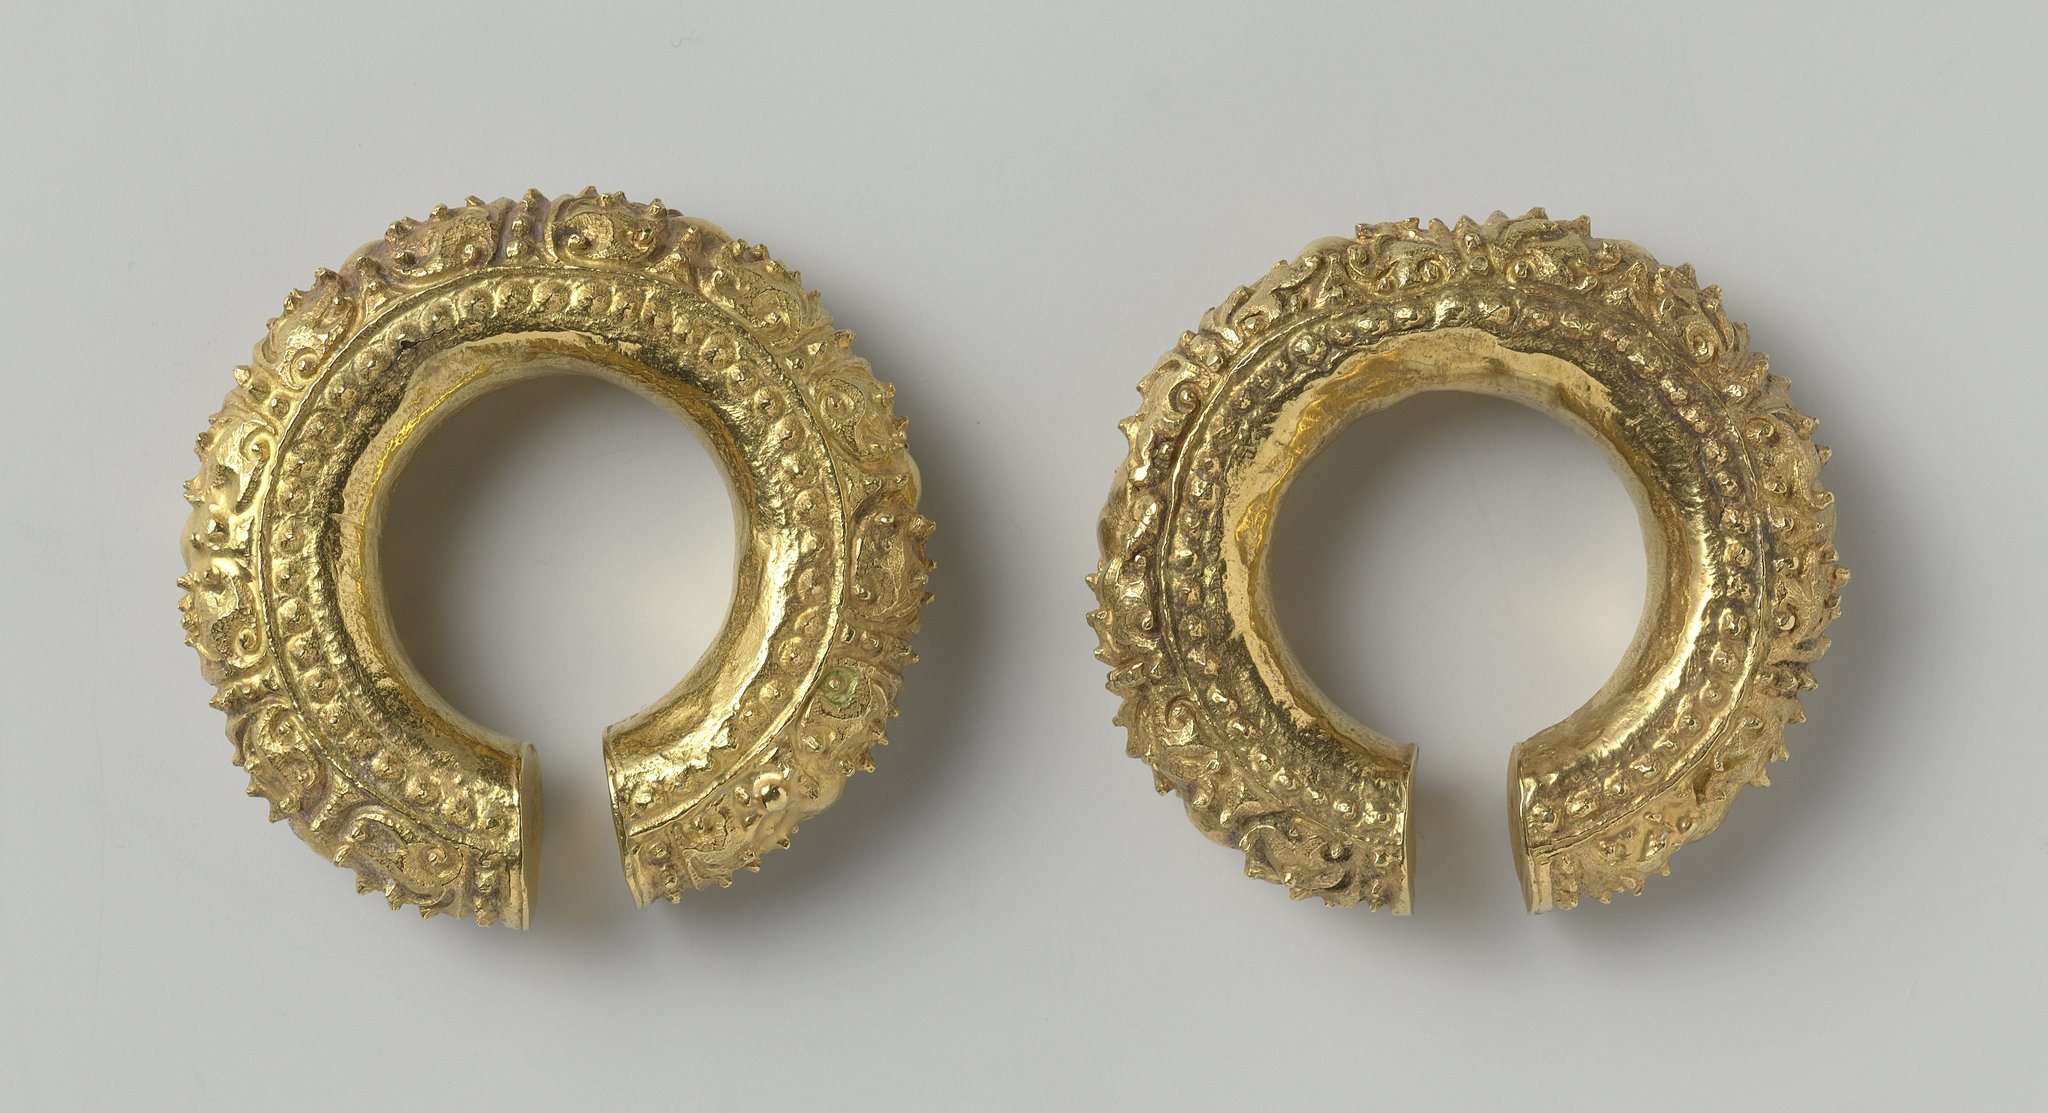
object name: ear ornament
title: Pair of earrings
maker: Anonymous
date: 1200-1400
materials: gold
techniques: repoussé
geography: east java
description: Een paar ooringen, elk verdeeld in zes panelen en opgevuld met gestileerde kalakoppen en florale motieven. Uitgevoerd in goud repoussé.